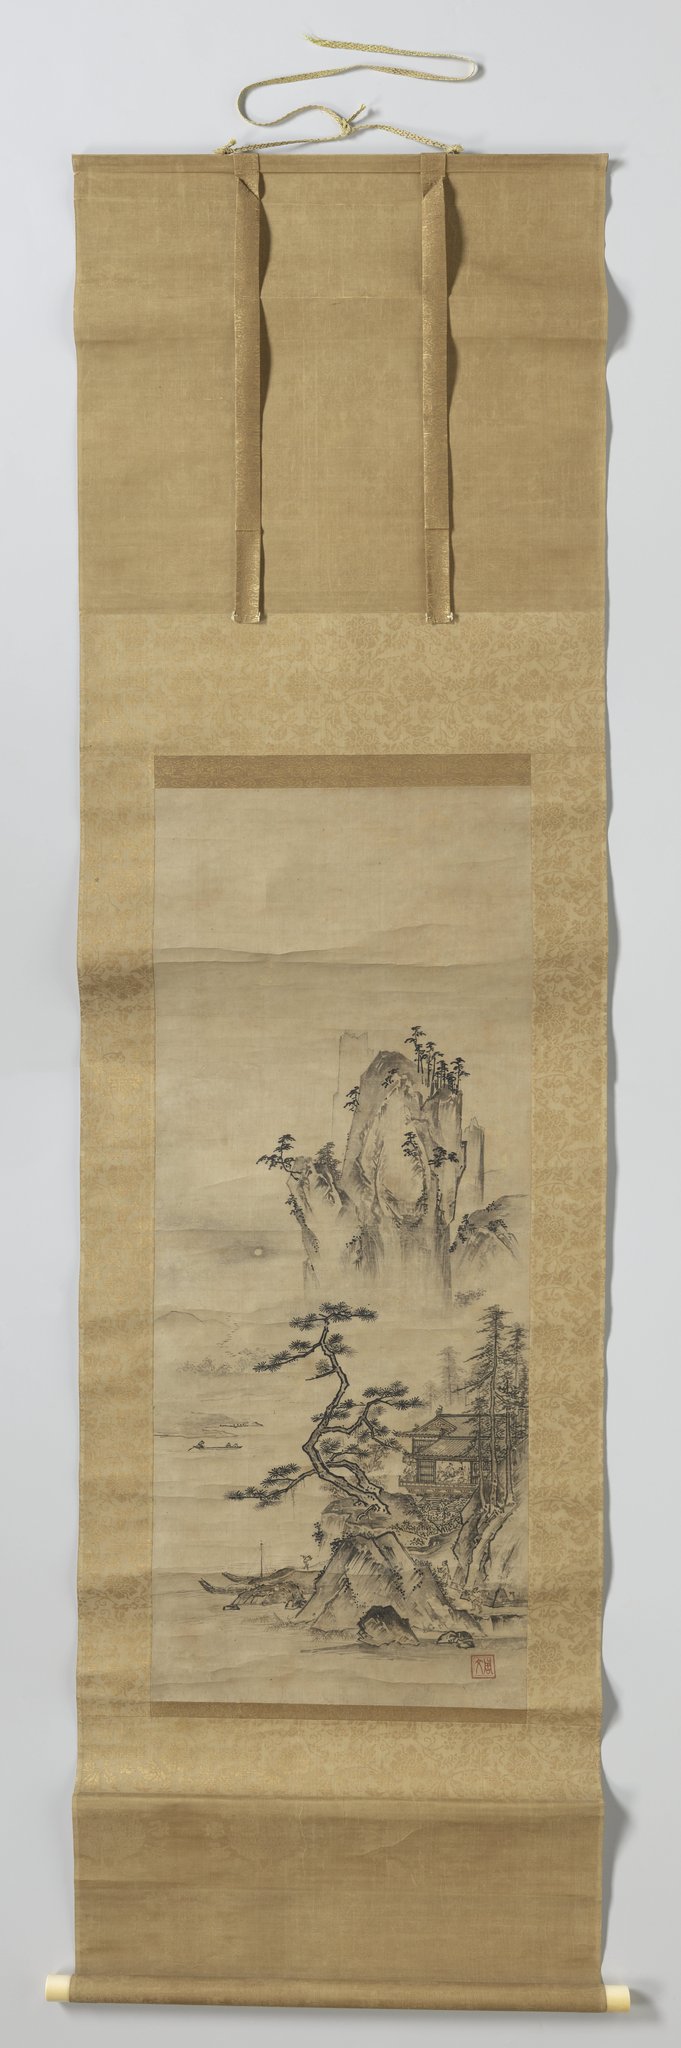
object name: hanging scroll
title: Landschap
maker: shubun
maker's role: painter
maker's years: 1418-1463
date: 1500-1700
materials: ink, paper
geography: japan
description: Mountain landscape by the water. Japan. 17th century. Ink on paper. Below right is the stamp of the famous painter Shubun (flourished 1414 -1463). However, the painting is a much later, respectful imitation of the master's style. This was not unusual in Chinese and Japanese art, where an artist was not always required to show originality. On loan from W.H. de Roos.